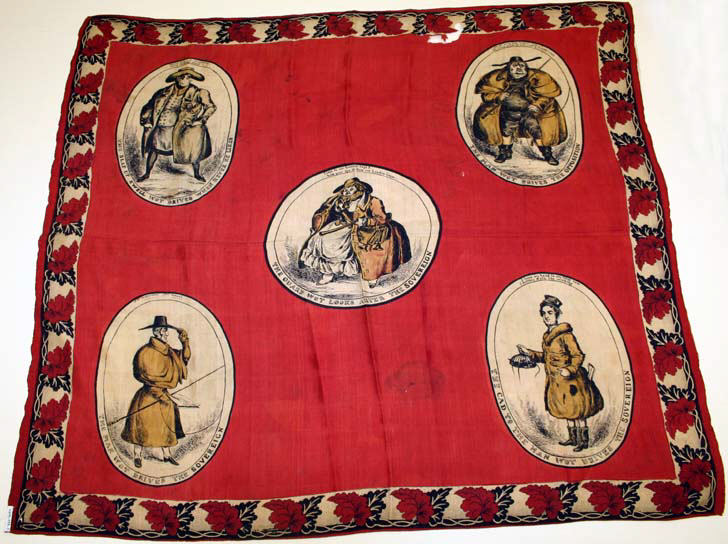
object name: scarf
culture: british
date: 1829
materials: silk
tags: men,caricature